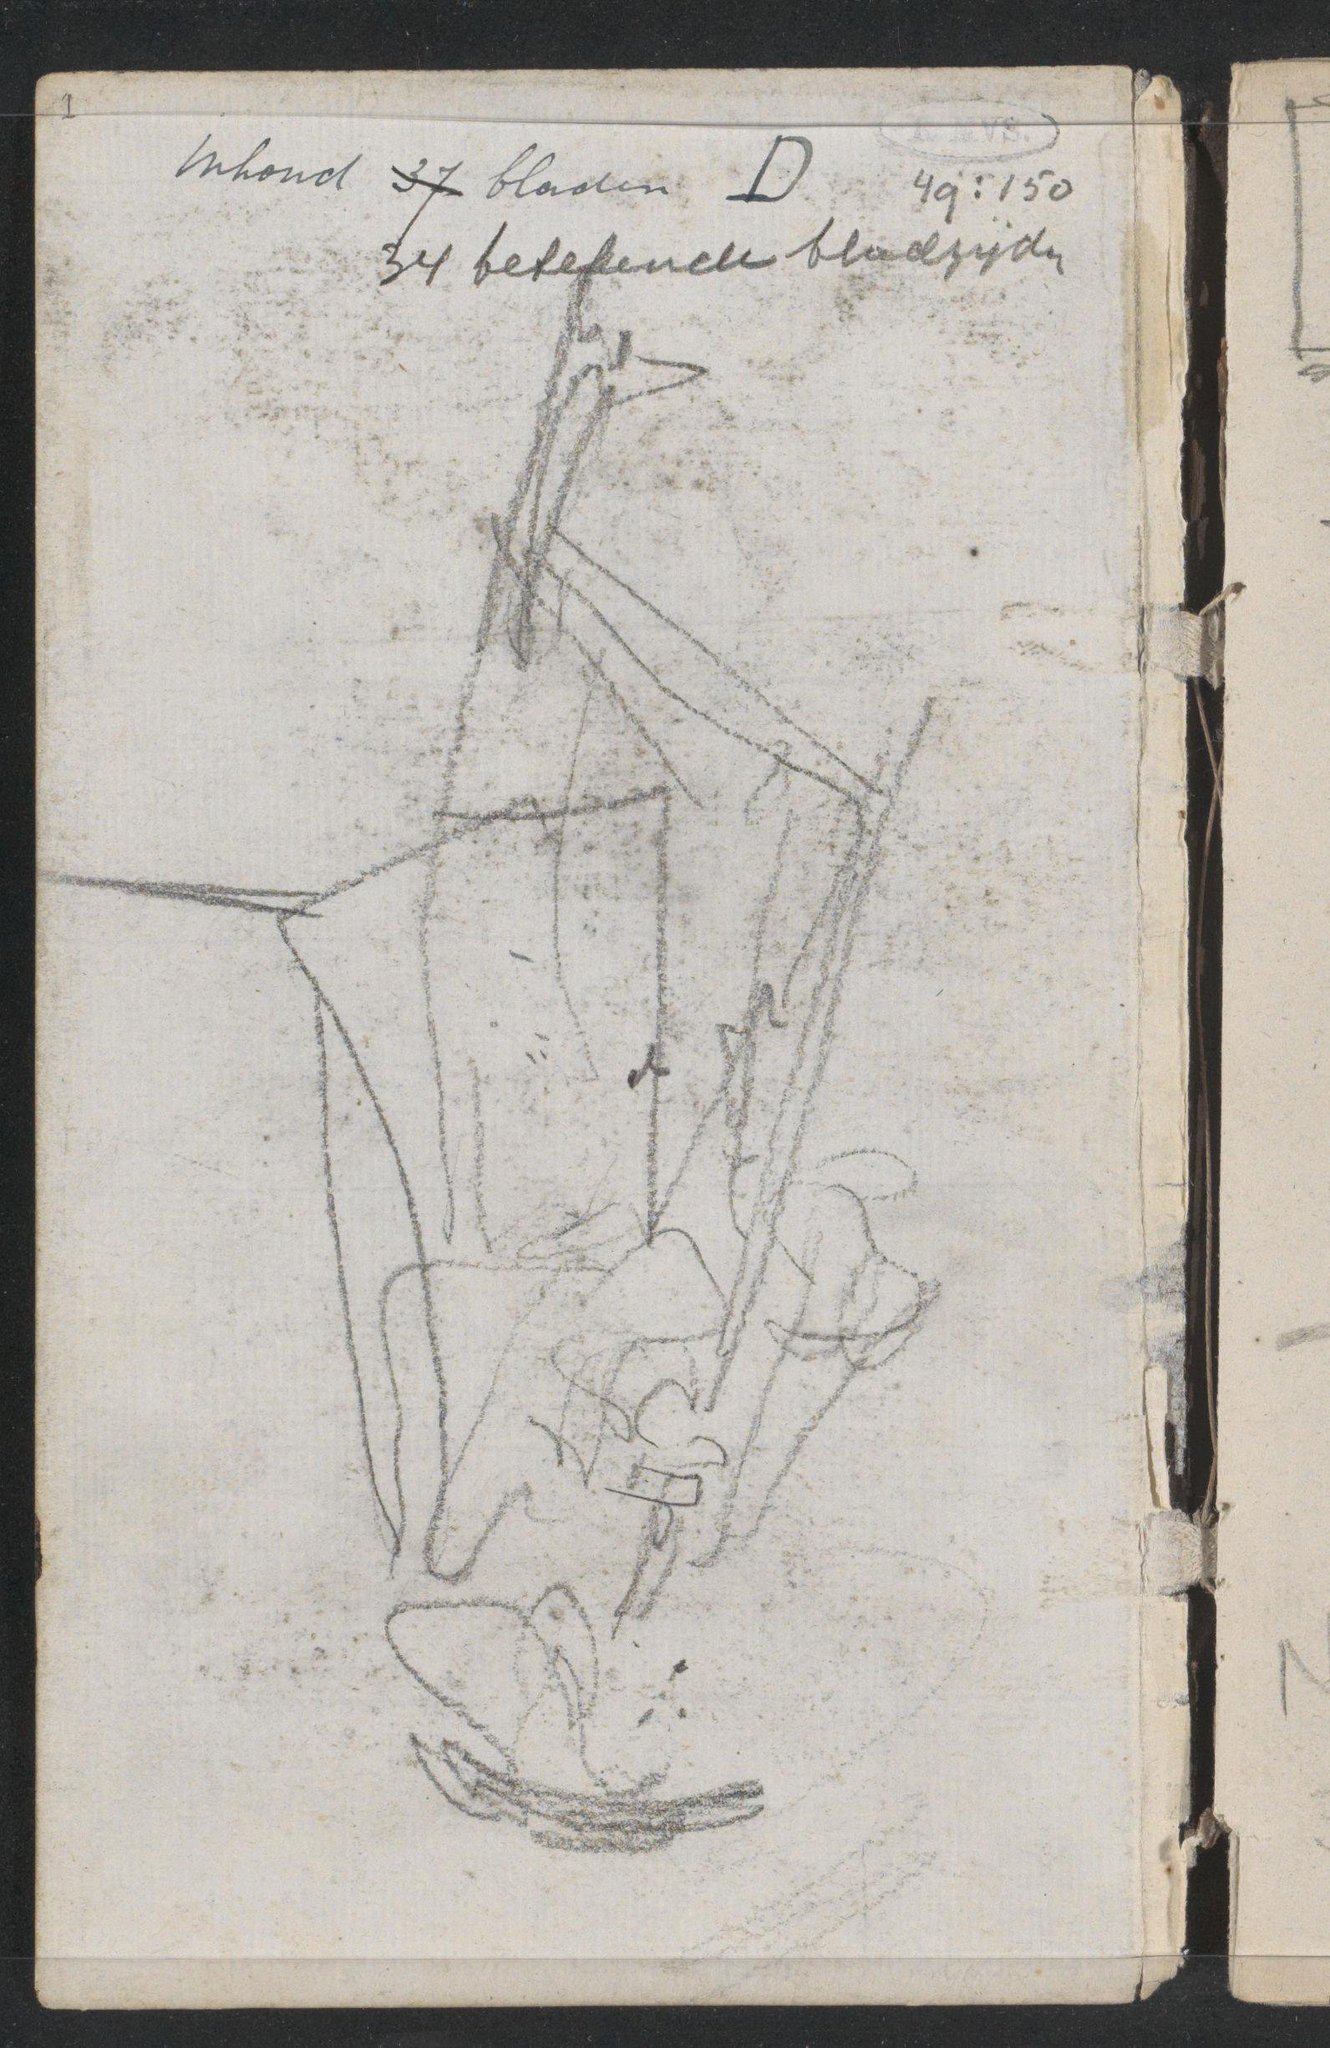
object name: sketchbook leaf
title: Staande figuur met hoed en stok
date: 1880-1882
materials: paper, pencil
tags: standing figure, walking-stick, staff, head-gear: hat (+ men's clothes)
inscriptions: collector's mark: Lugt 2228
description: Schutblad A, voorste schutblad, uit een schetsboek met 10 bladen.